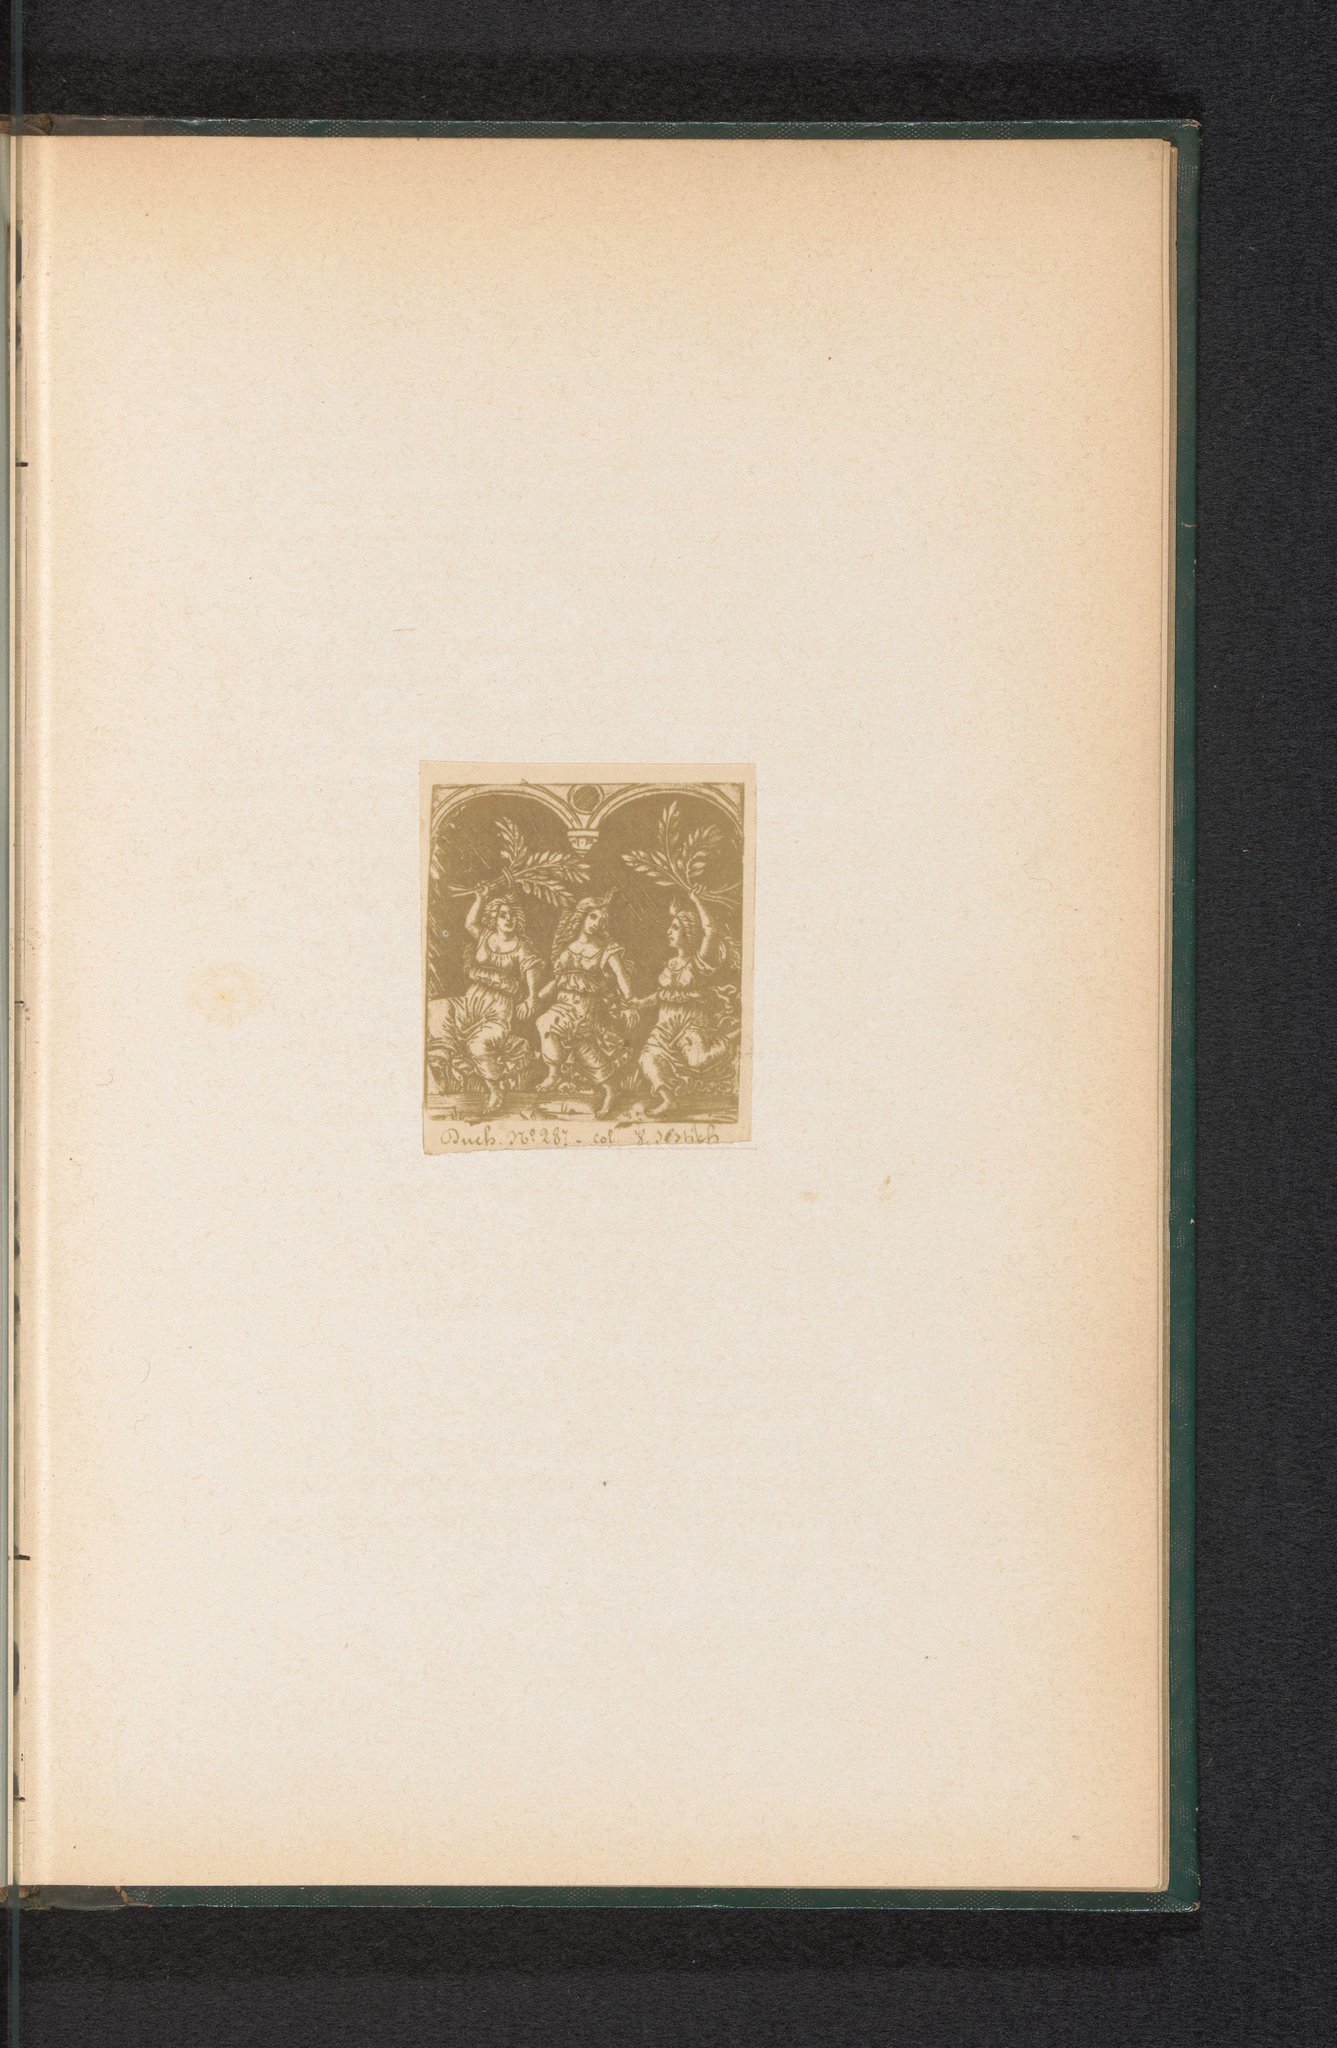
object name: reproduction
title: Fotoreproductie van een prent van drie dansende vrouwen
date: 1852-1857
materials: photographic support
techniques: salted paper print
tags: adult woman, dancing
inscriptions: inscription: ‘Duch. No 287 - col. V. Sestich’